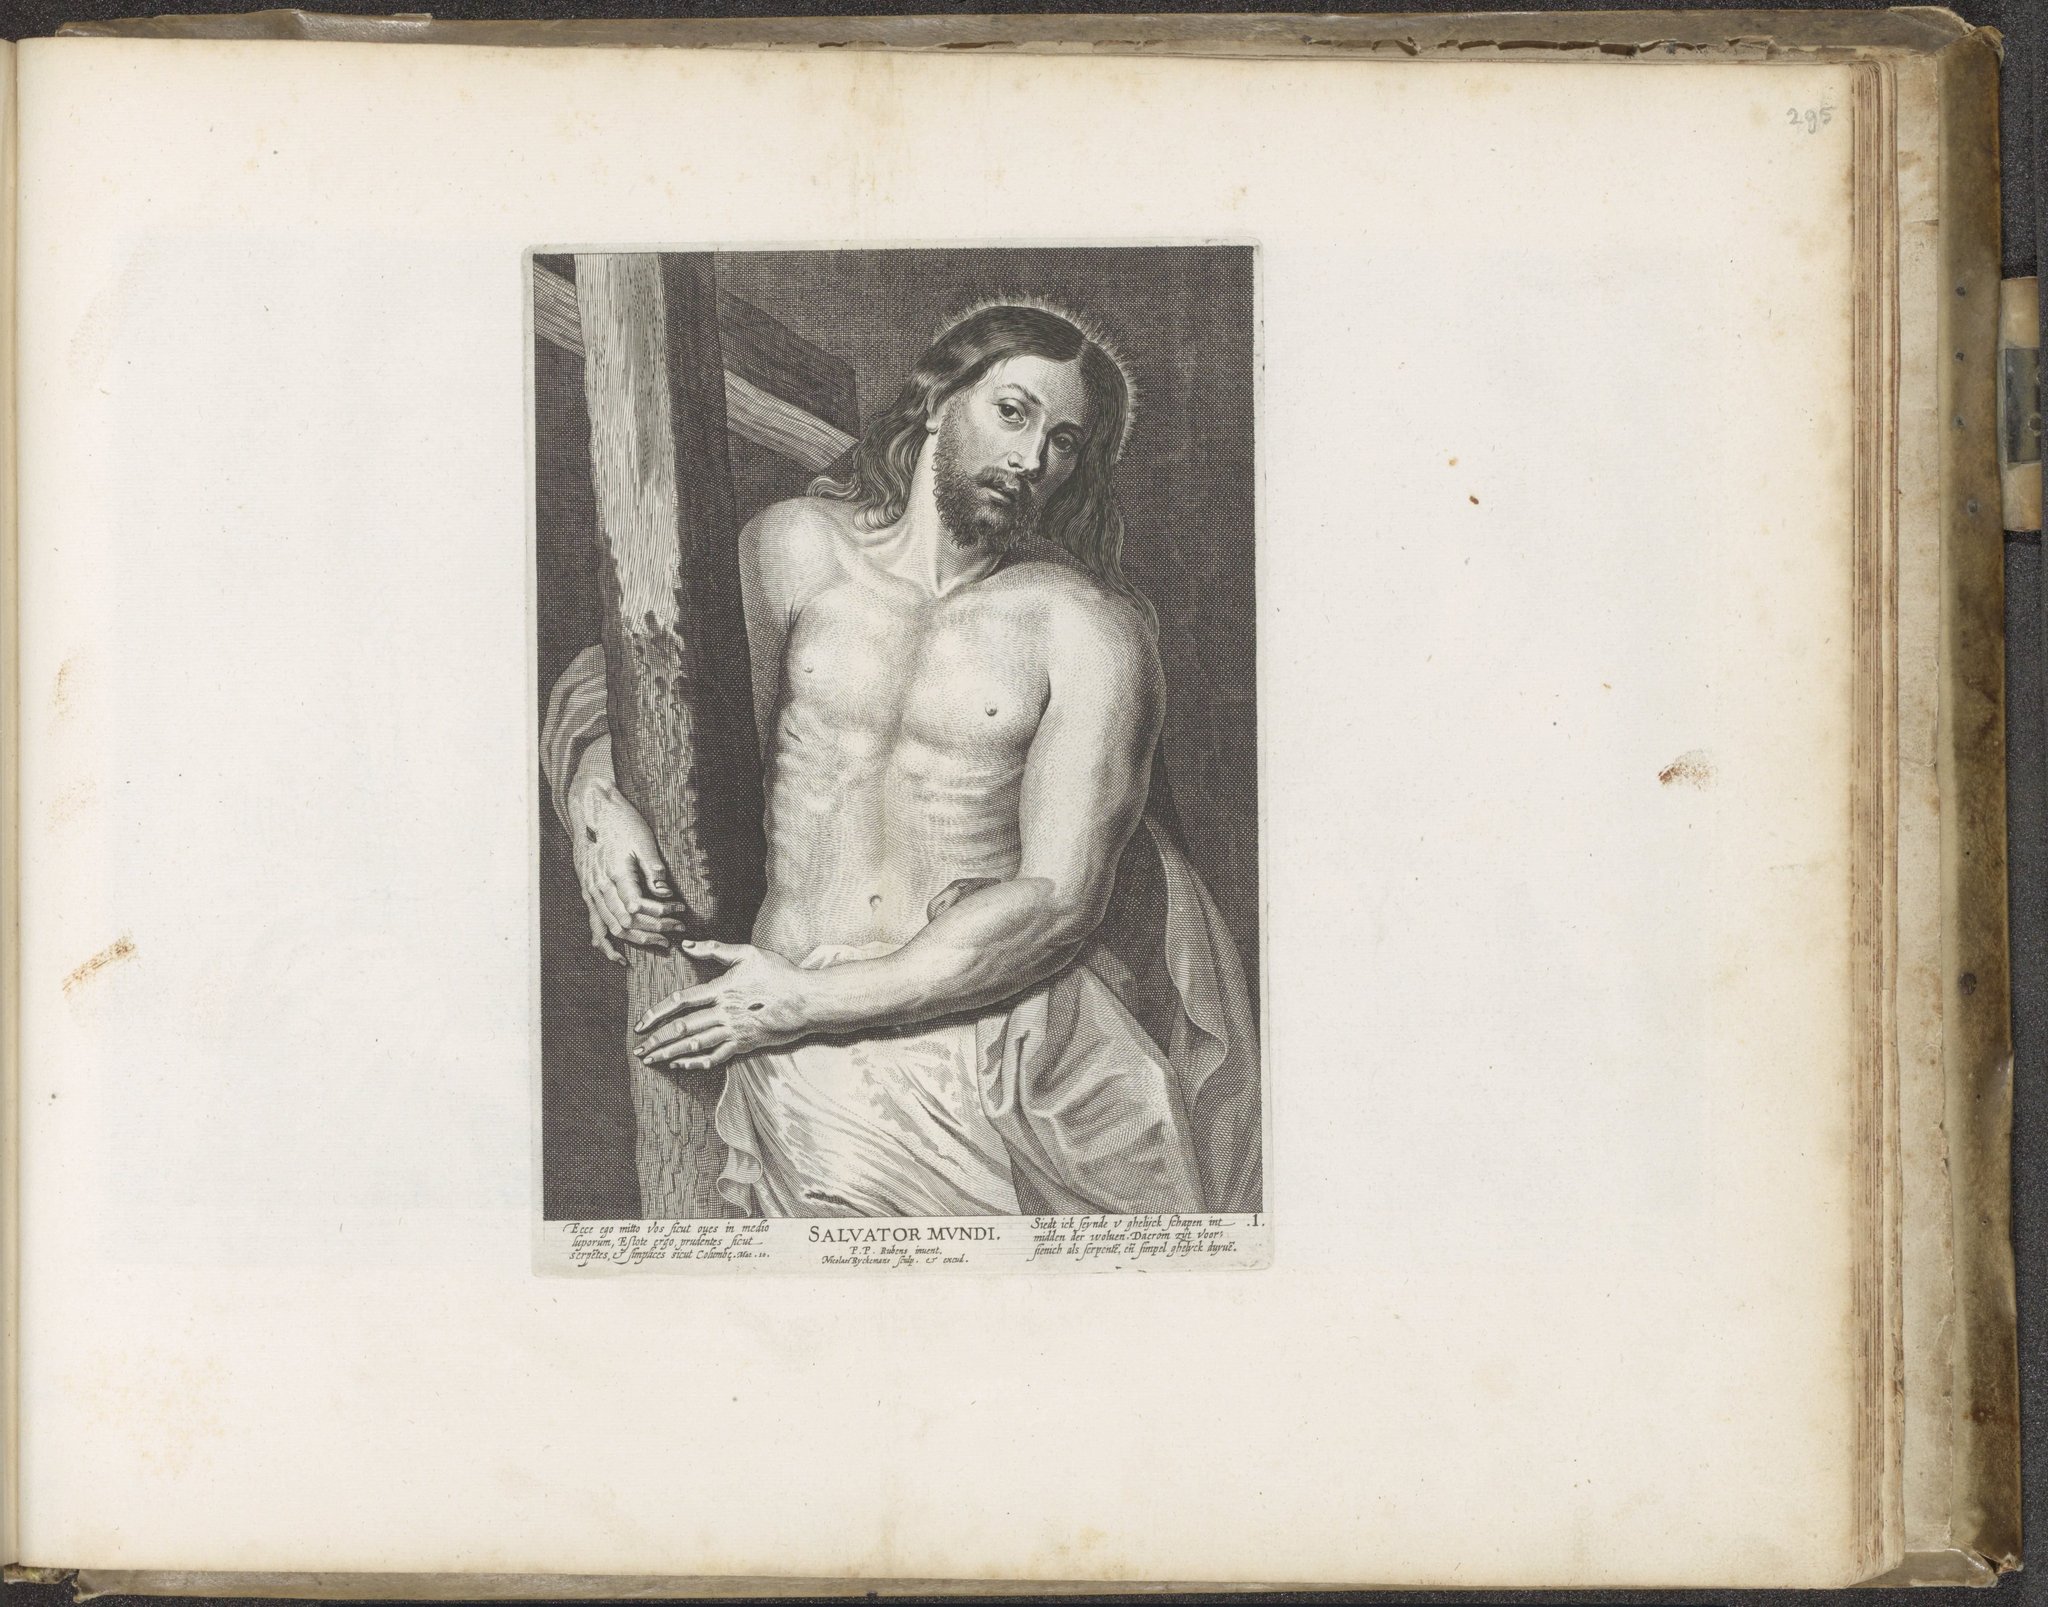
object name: album leaf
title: Christus met het kruis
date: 1616-1626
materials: paper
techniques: engraving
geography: amsterdam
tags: christ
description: Christus met het kruis. In de ondermarge de Bijbeltekst van Mattëus 10:16 in het Latijn en het Nederlands. De prent maakt deel uit van een album.